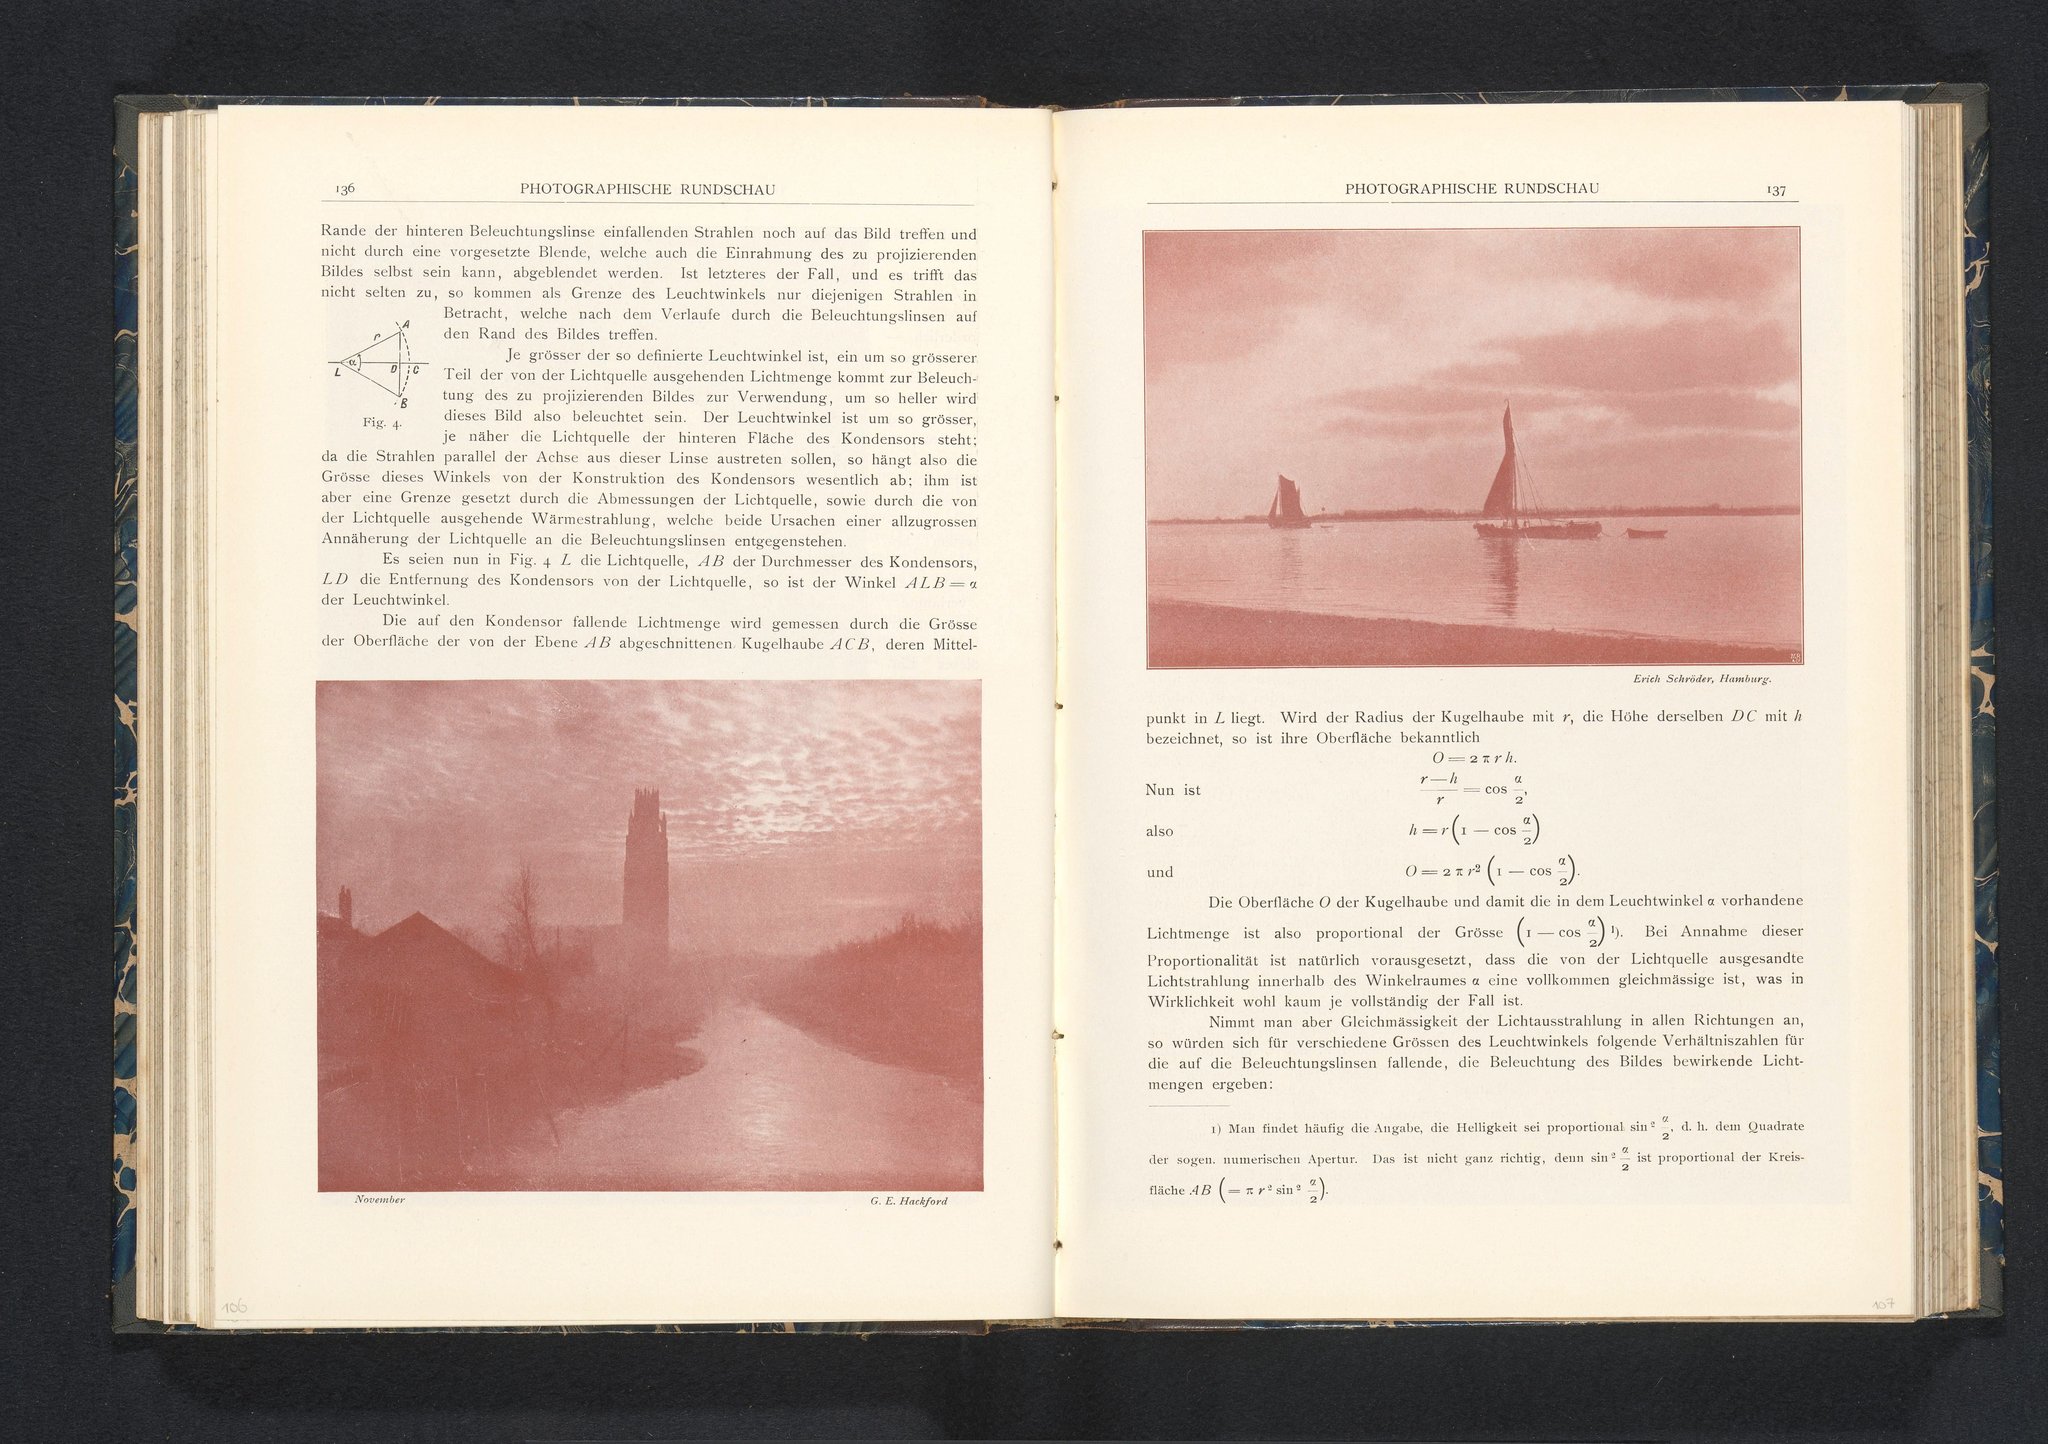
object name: page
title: Gezicht op een waterweg, met op de achtergrond een kerktoren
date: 1896-1901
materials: paper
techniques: autotype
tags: water course, church (exterior)